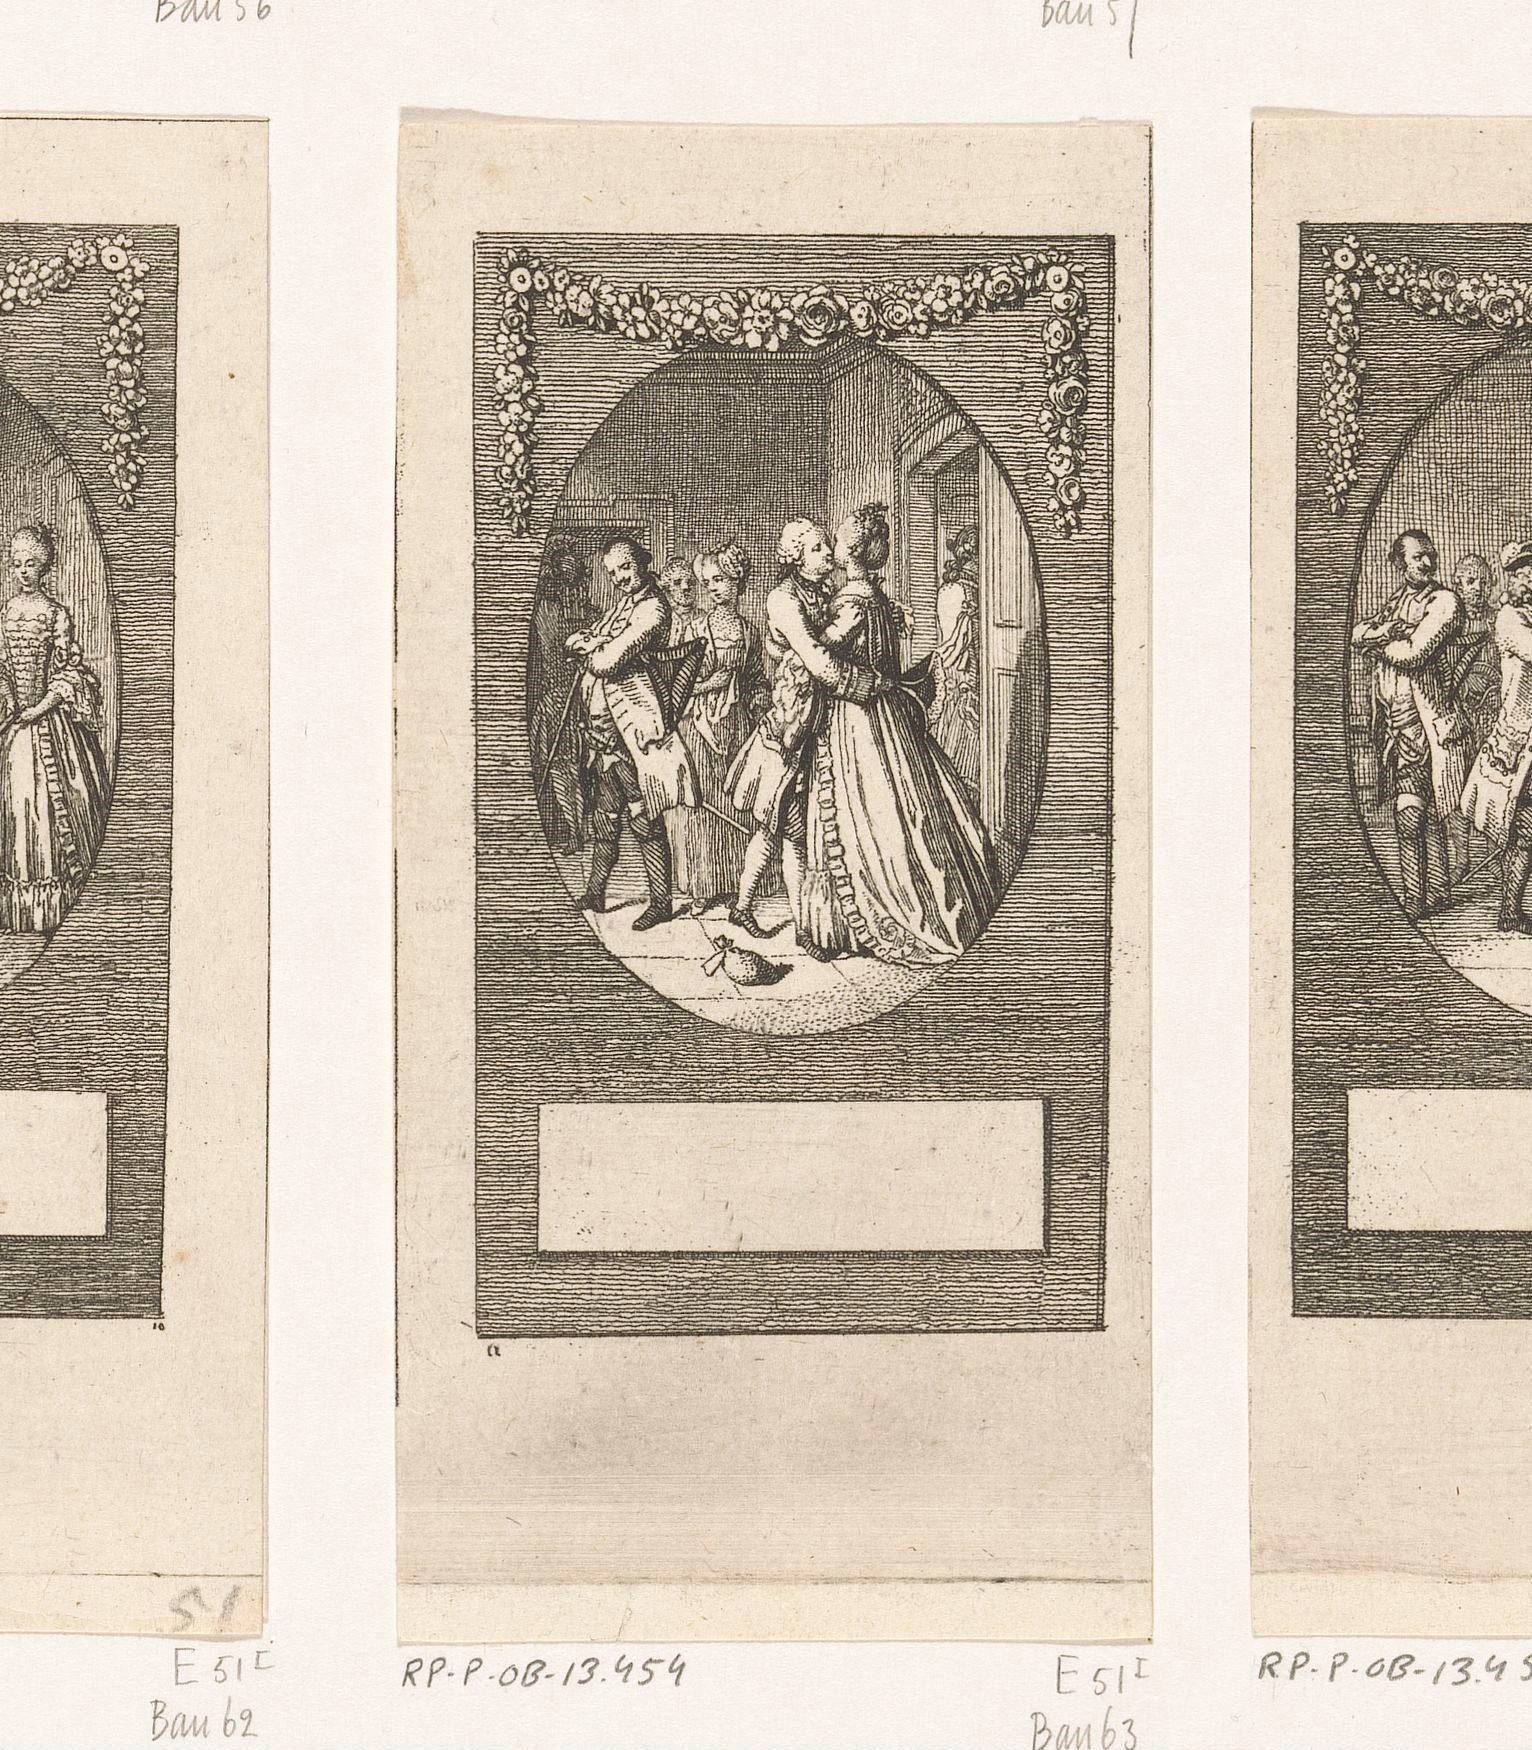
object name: print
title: Major Tellheim en Minna von Barnhelm kussen elkaar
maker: daniel nikolaus chodowiecki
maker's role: draughtsman, print maker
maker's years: 1726-1801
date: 1769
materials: paper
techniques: etching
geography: berlin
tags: (lovers) kissing each other, literary characters and objects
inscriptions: collector's mark: Lugt 2228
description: Deze prent maakt onderdeel uit van een serie van twaalf scènes die het toneelstuk 'Minna von Barnhelm' van Gotthold Ephraim Lessing illustreren (eerste uitvoering 1767). Chodowiecki bracht het toneelstuk twee keer in prent, een met onderschriften in het Frans en een met onderschriften in het Duits. Bij beide series werden de scènes op een plaat geëtst. Deze prent hoort bij de Franse serie, gebruikt als boekillustratie in: 'Almanac Genealogique pour l'an 1770'.